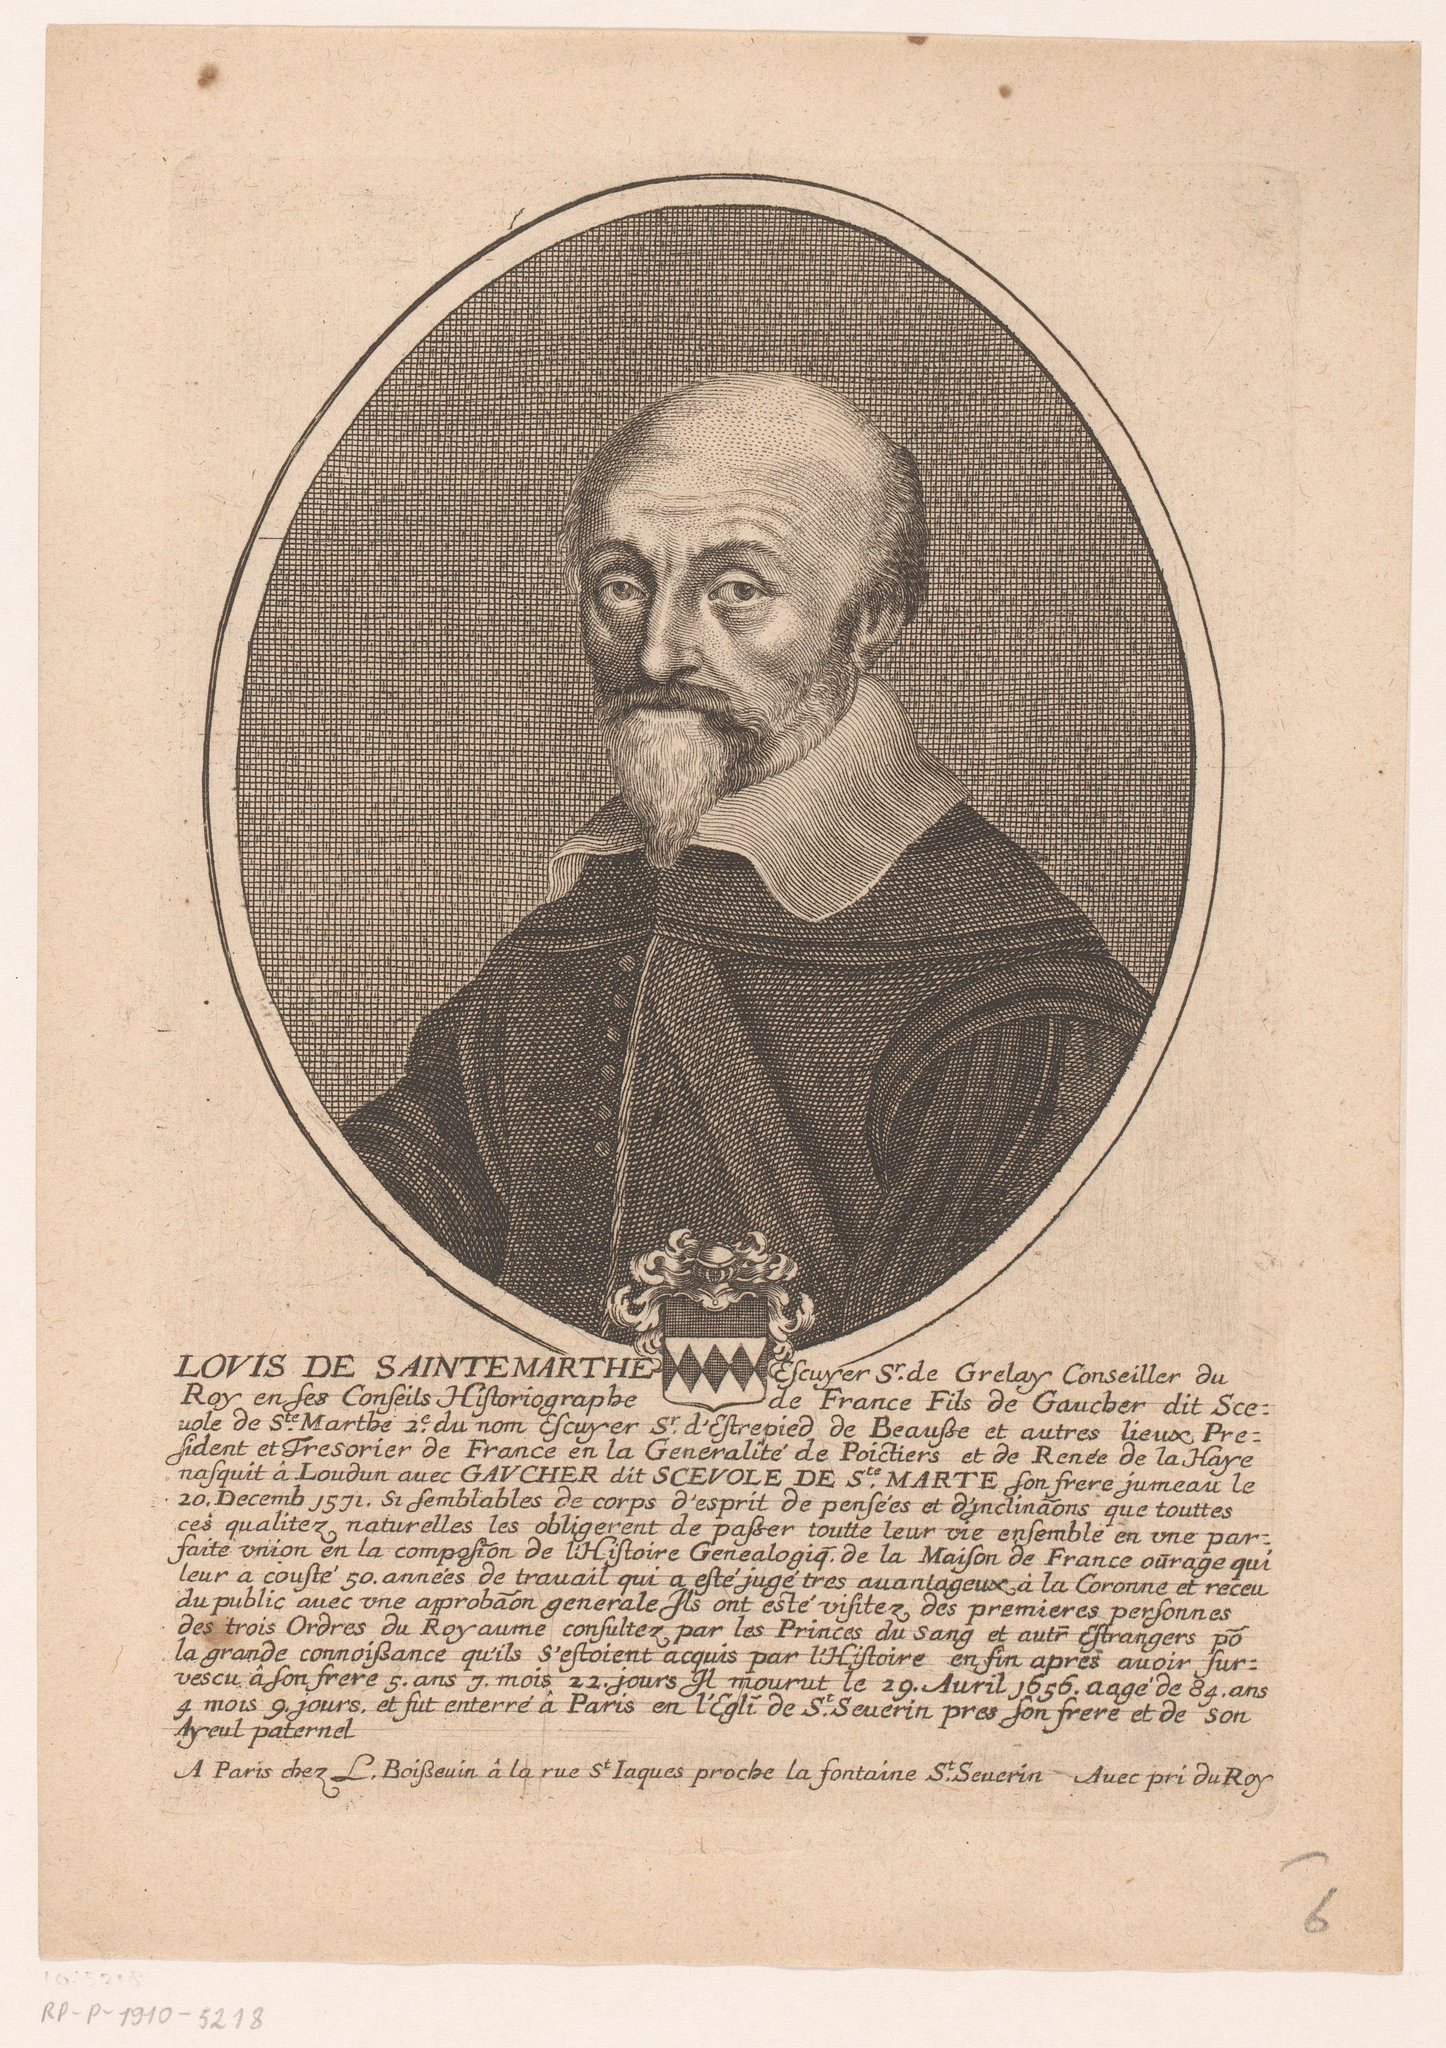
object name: print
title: Portret van Louis de Sainte-Marthe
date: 1656-1676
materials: paper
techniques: engraving, etching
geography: france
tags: ornament ~ medallion, historical persons, armorial bearing, heraldry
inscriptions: collector's mark: Lugt 2228